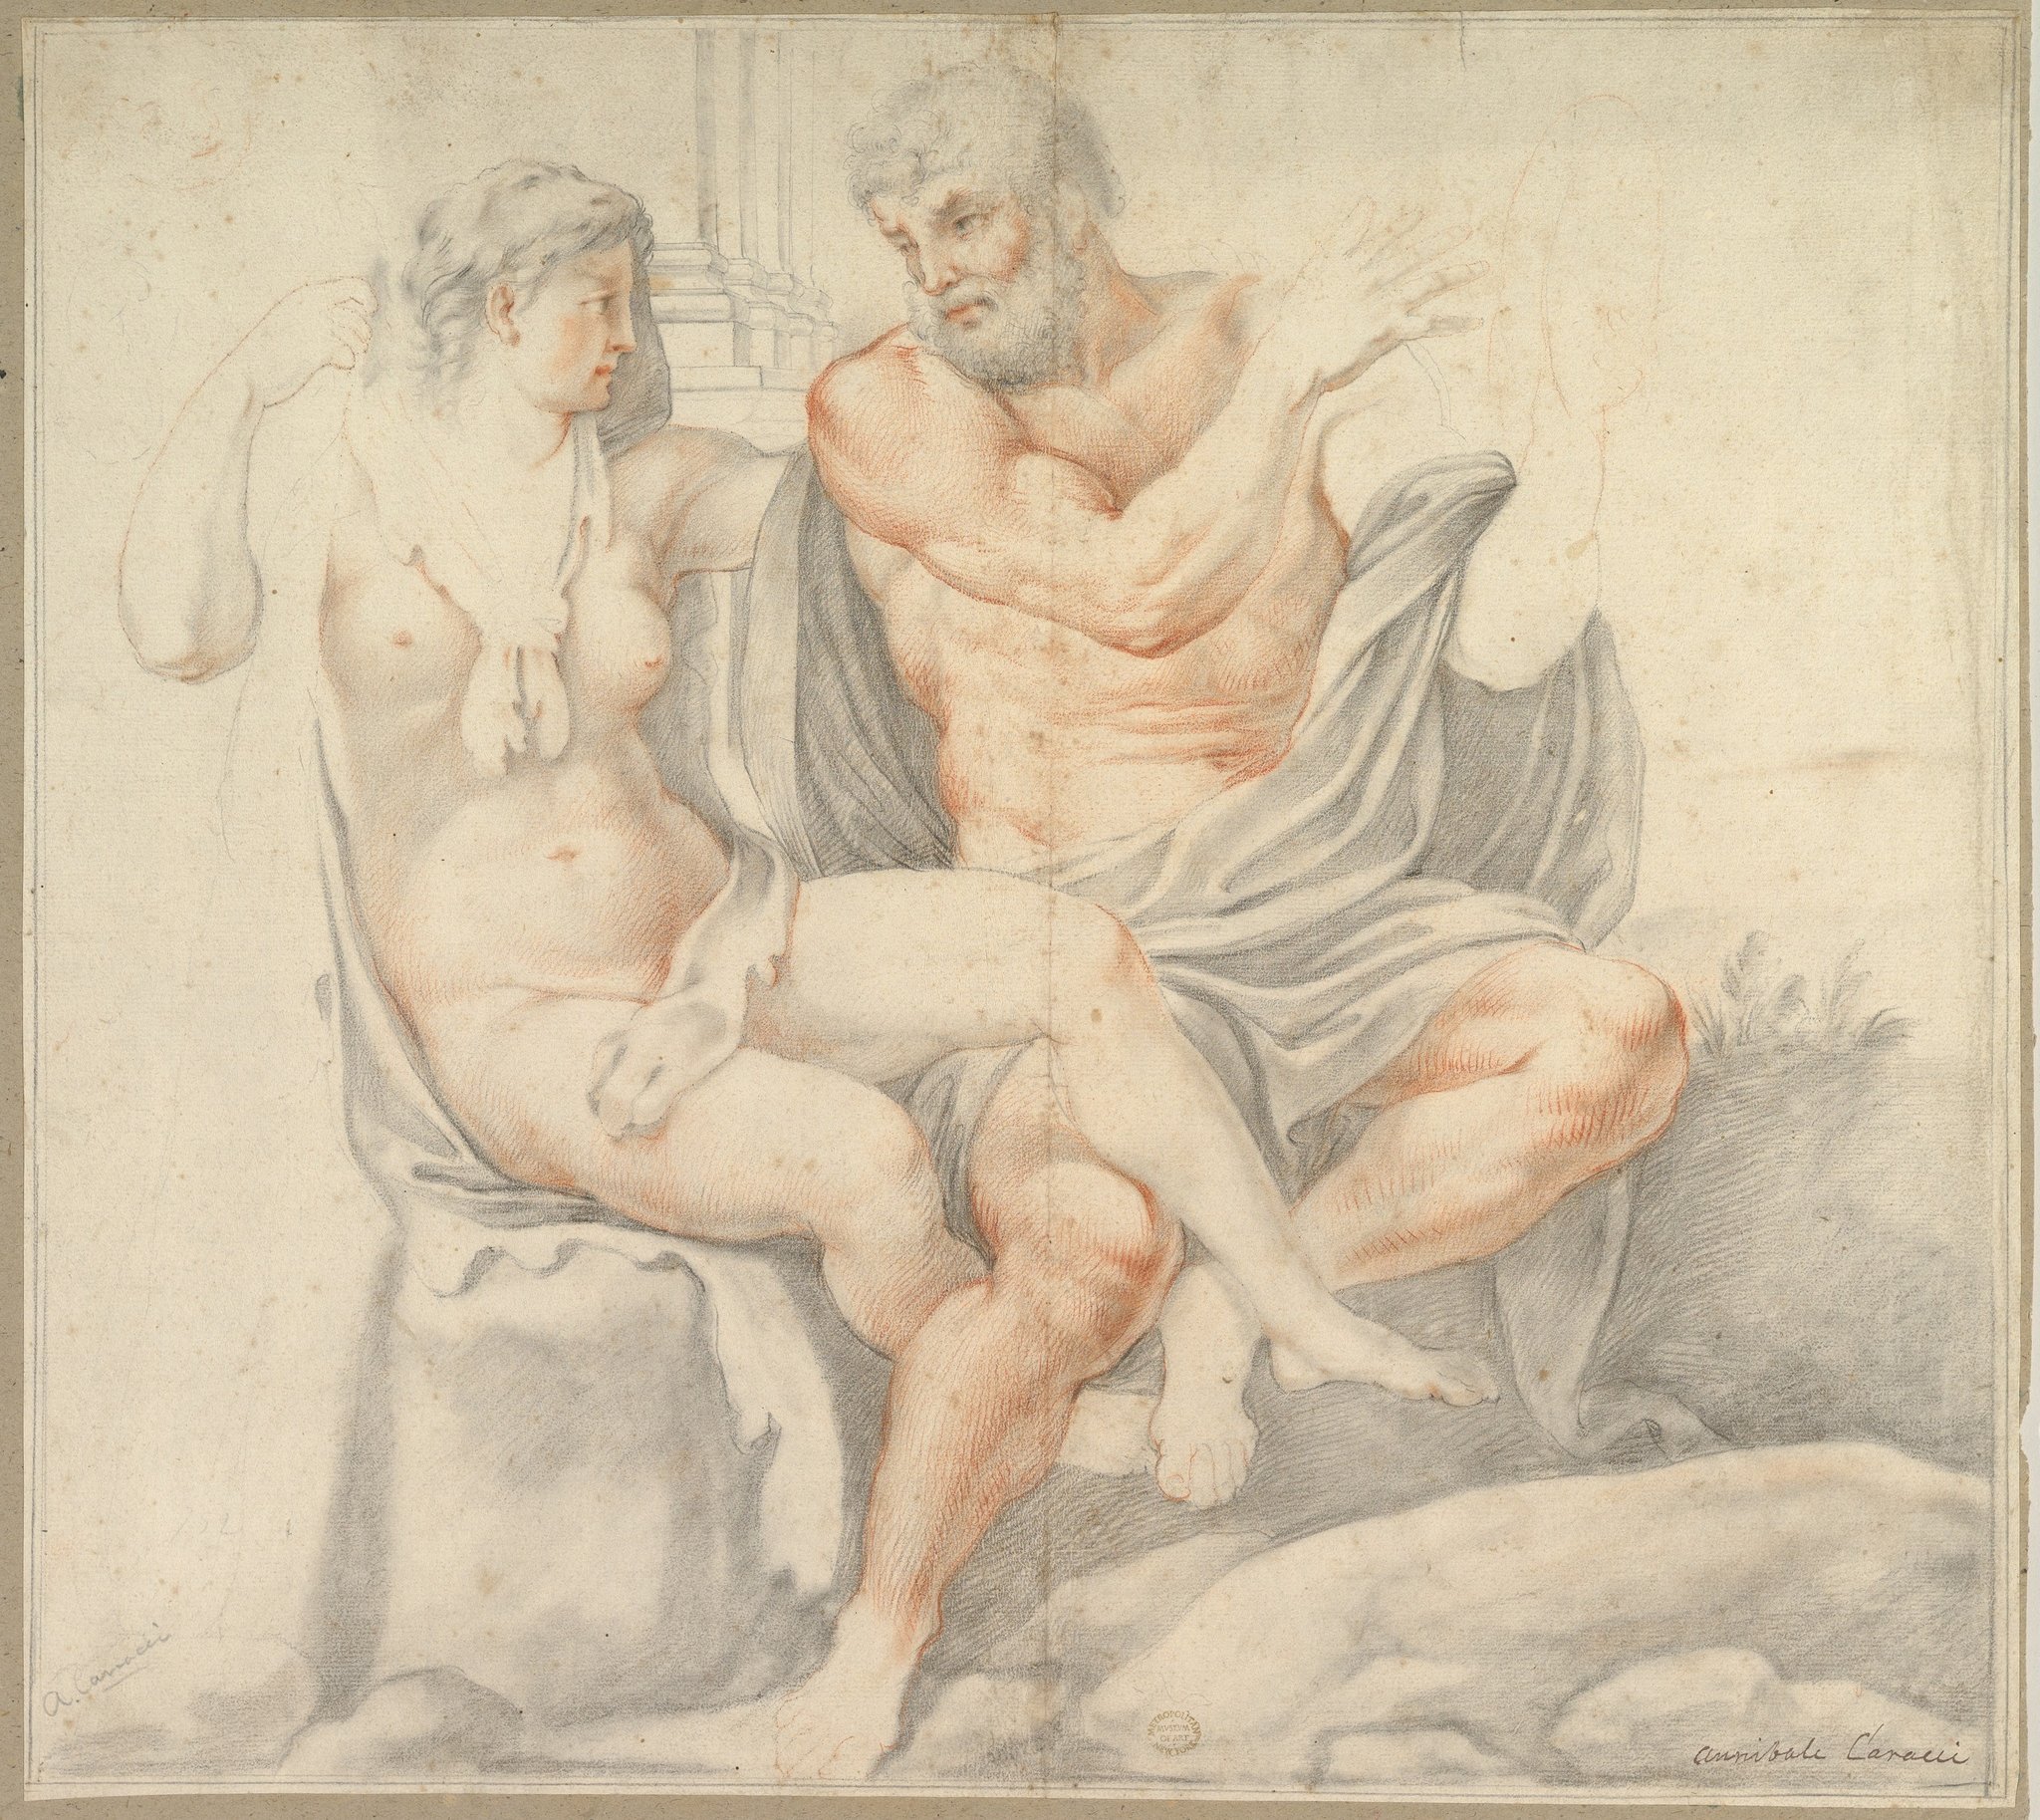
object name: drawing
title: Hercules and Omphale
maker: annibale carracci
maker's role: artist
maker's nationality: italian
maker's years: 1560-1609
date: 1560-1609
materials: chalk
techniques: transfer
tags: female nudes,hercules